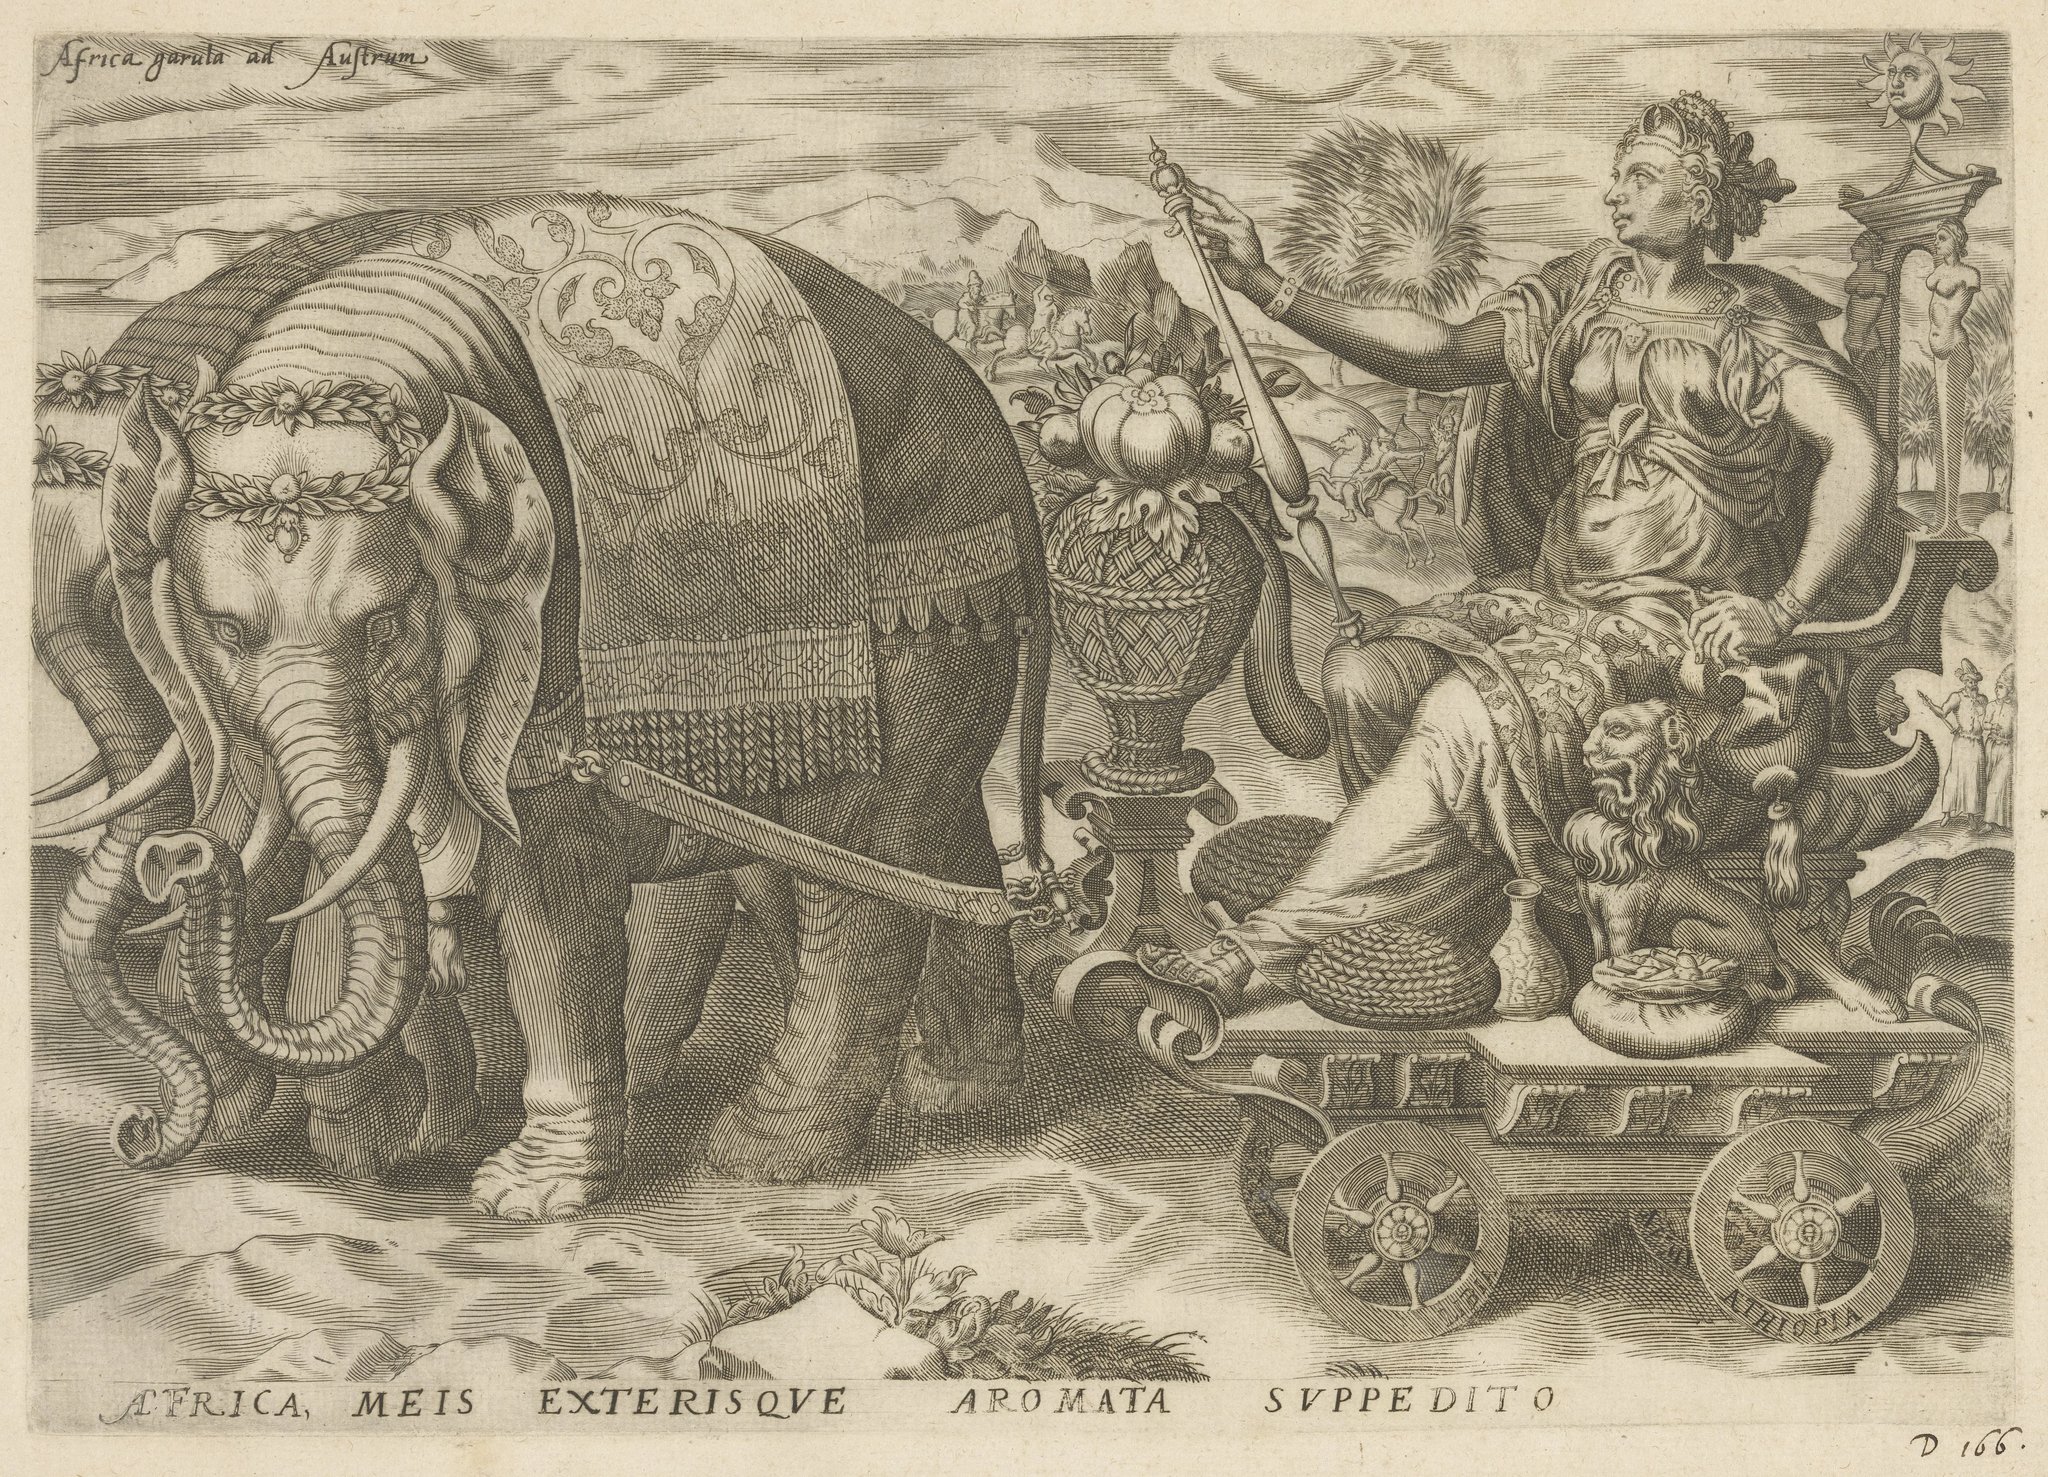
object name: print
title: Vier Werelddelen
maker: Anonymous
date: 1570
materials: paper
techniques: engraving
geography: italy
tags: africa represented allegorically; 'africa' (ripa), chariot, triumphal car, trunked animals: elephant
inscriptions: collector's mark: Lugt 2760, collector's mark: Lugt 2228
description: Triomfwagen van het werelddeel Afrika. Triomfwagen getrokken door olifanten. Prent uit serie van vier werelddelen.